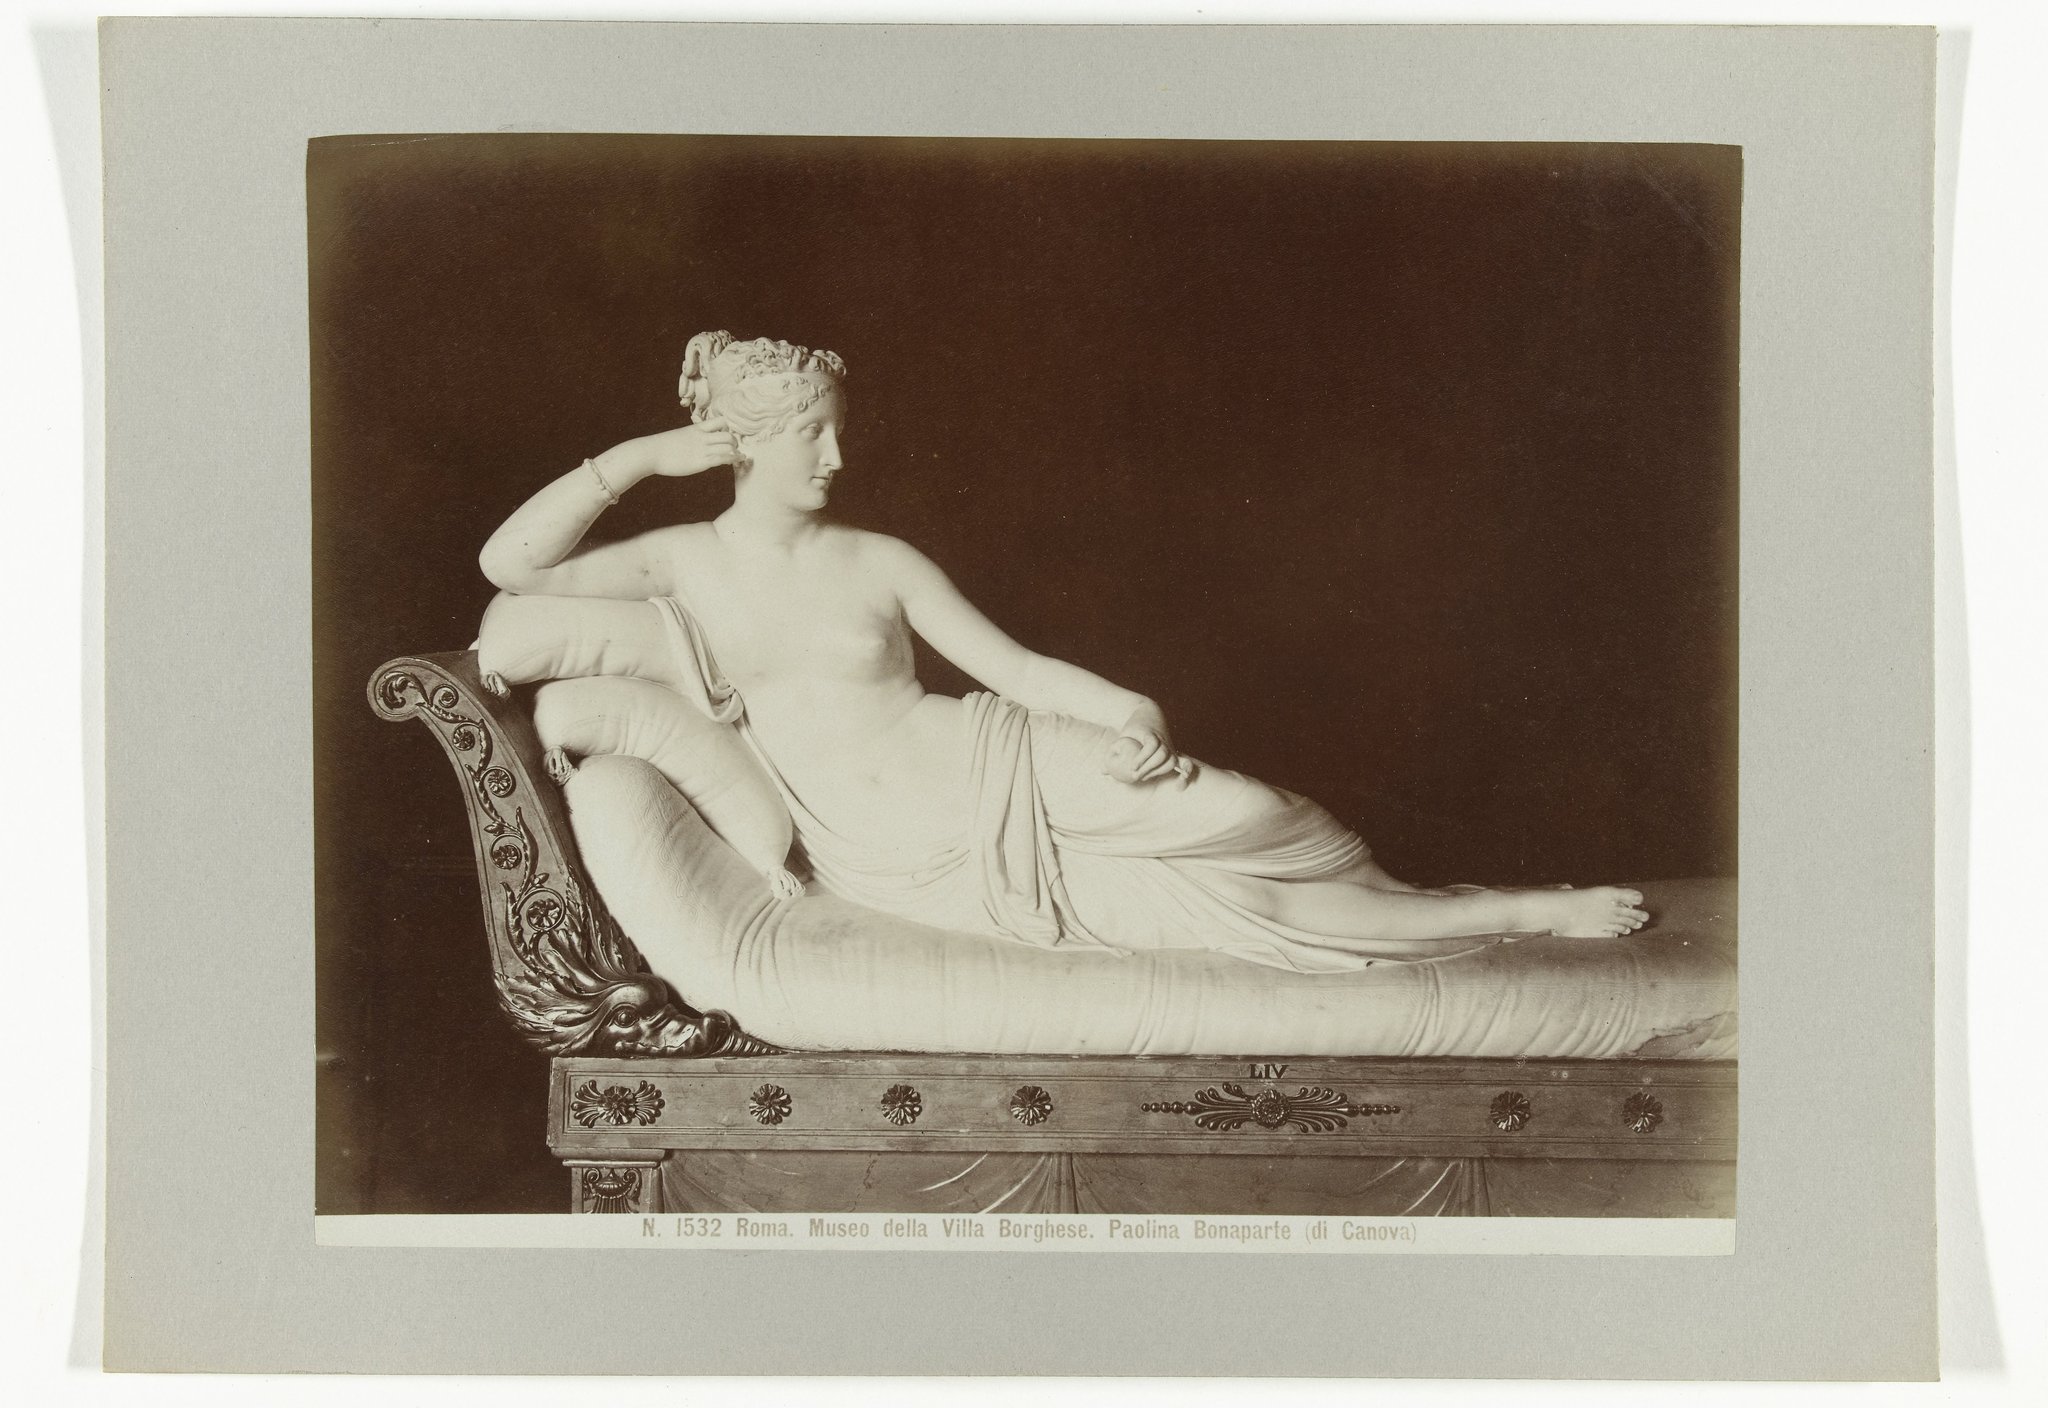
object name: photograph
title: N. 1532 Roma. Museo della Villa Borghese. Paolina Bonaparte (di Canova)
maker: Anonymous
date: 1880-1904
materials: cardboard, paper, photographic support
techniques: albumen print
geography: rome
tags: rome